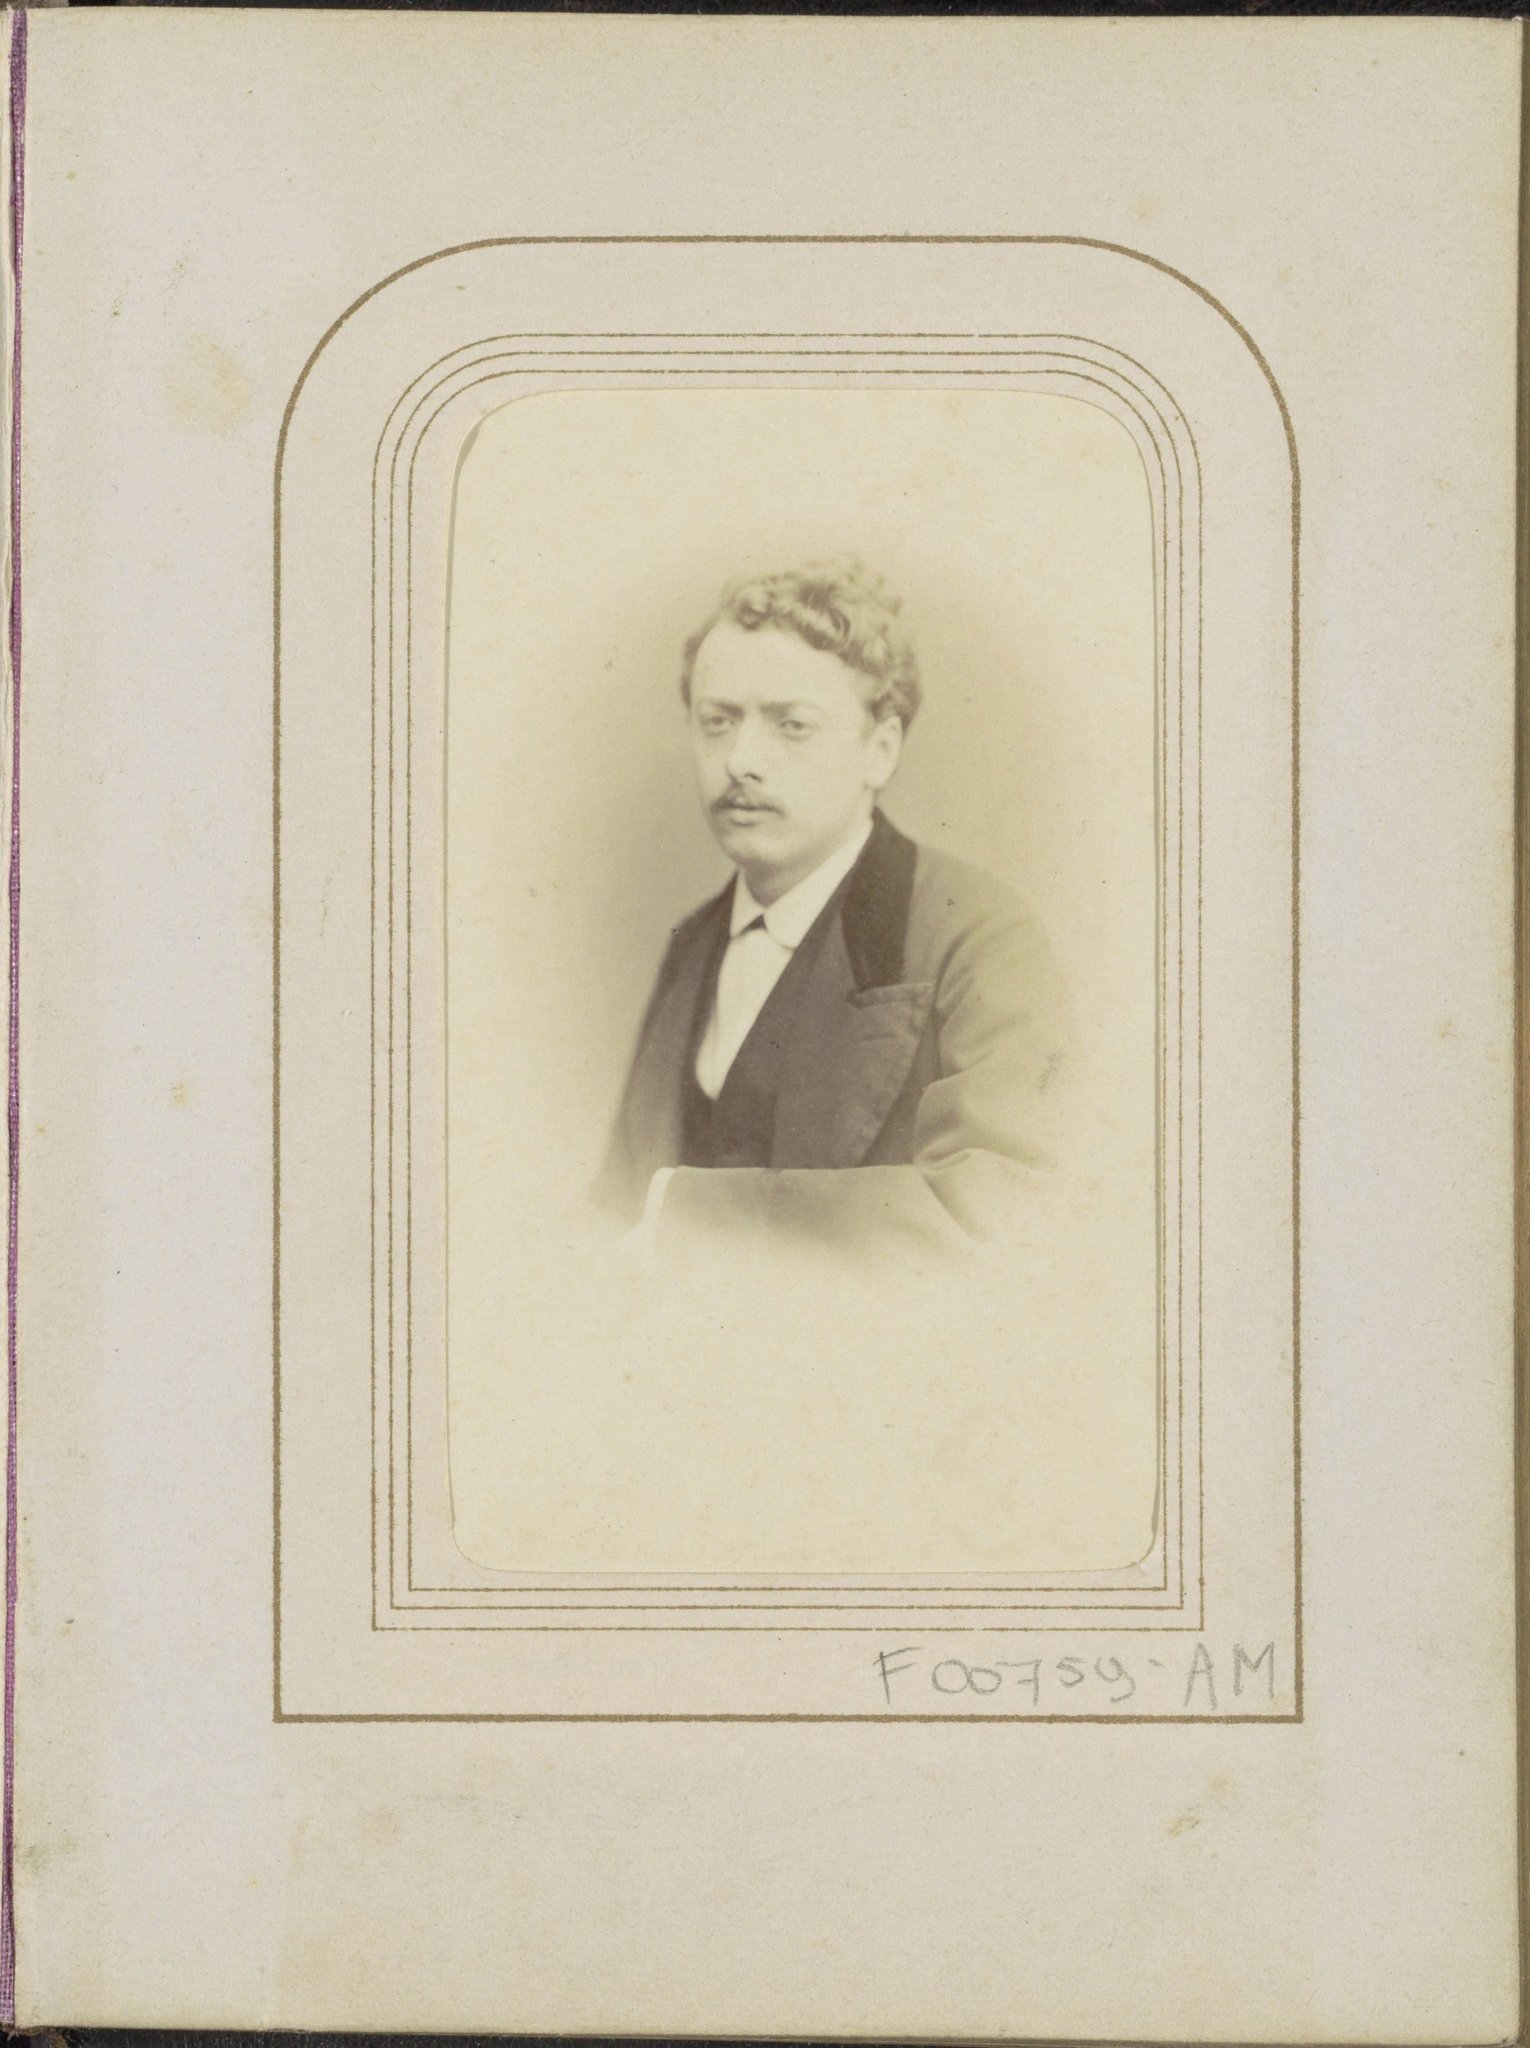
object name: carte de visite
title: Portret van een man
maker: albert greiner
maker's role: fotograaf, fotostudio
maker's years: 1833-1890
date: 1862-1885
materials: cardboard, paper, photographic support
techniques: albumen print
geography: amsterdam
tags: historical persons, amsterdam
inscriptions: address: ‘Amsterdam, Nieuwendijk L87’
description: Onderdeel van Fotoalbum van een Nederlandse familie met 50 cartes-de-visite.